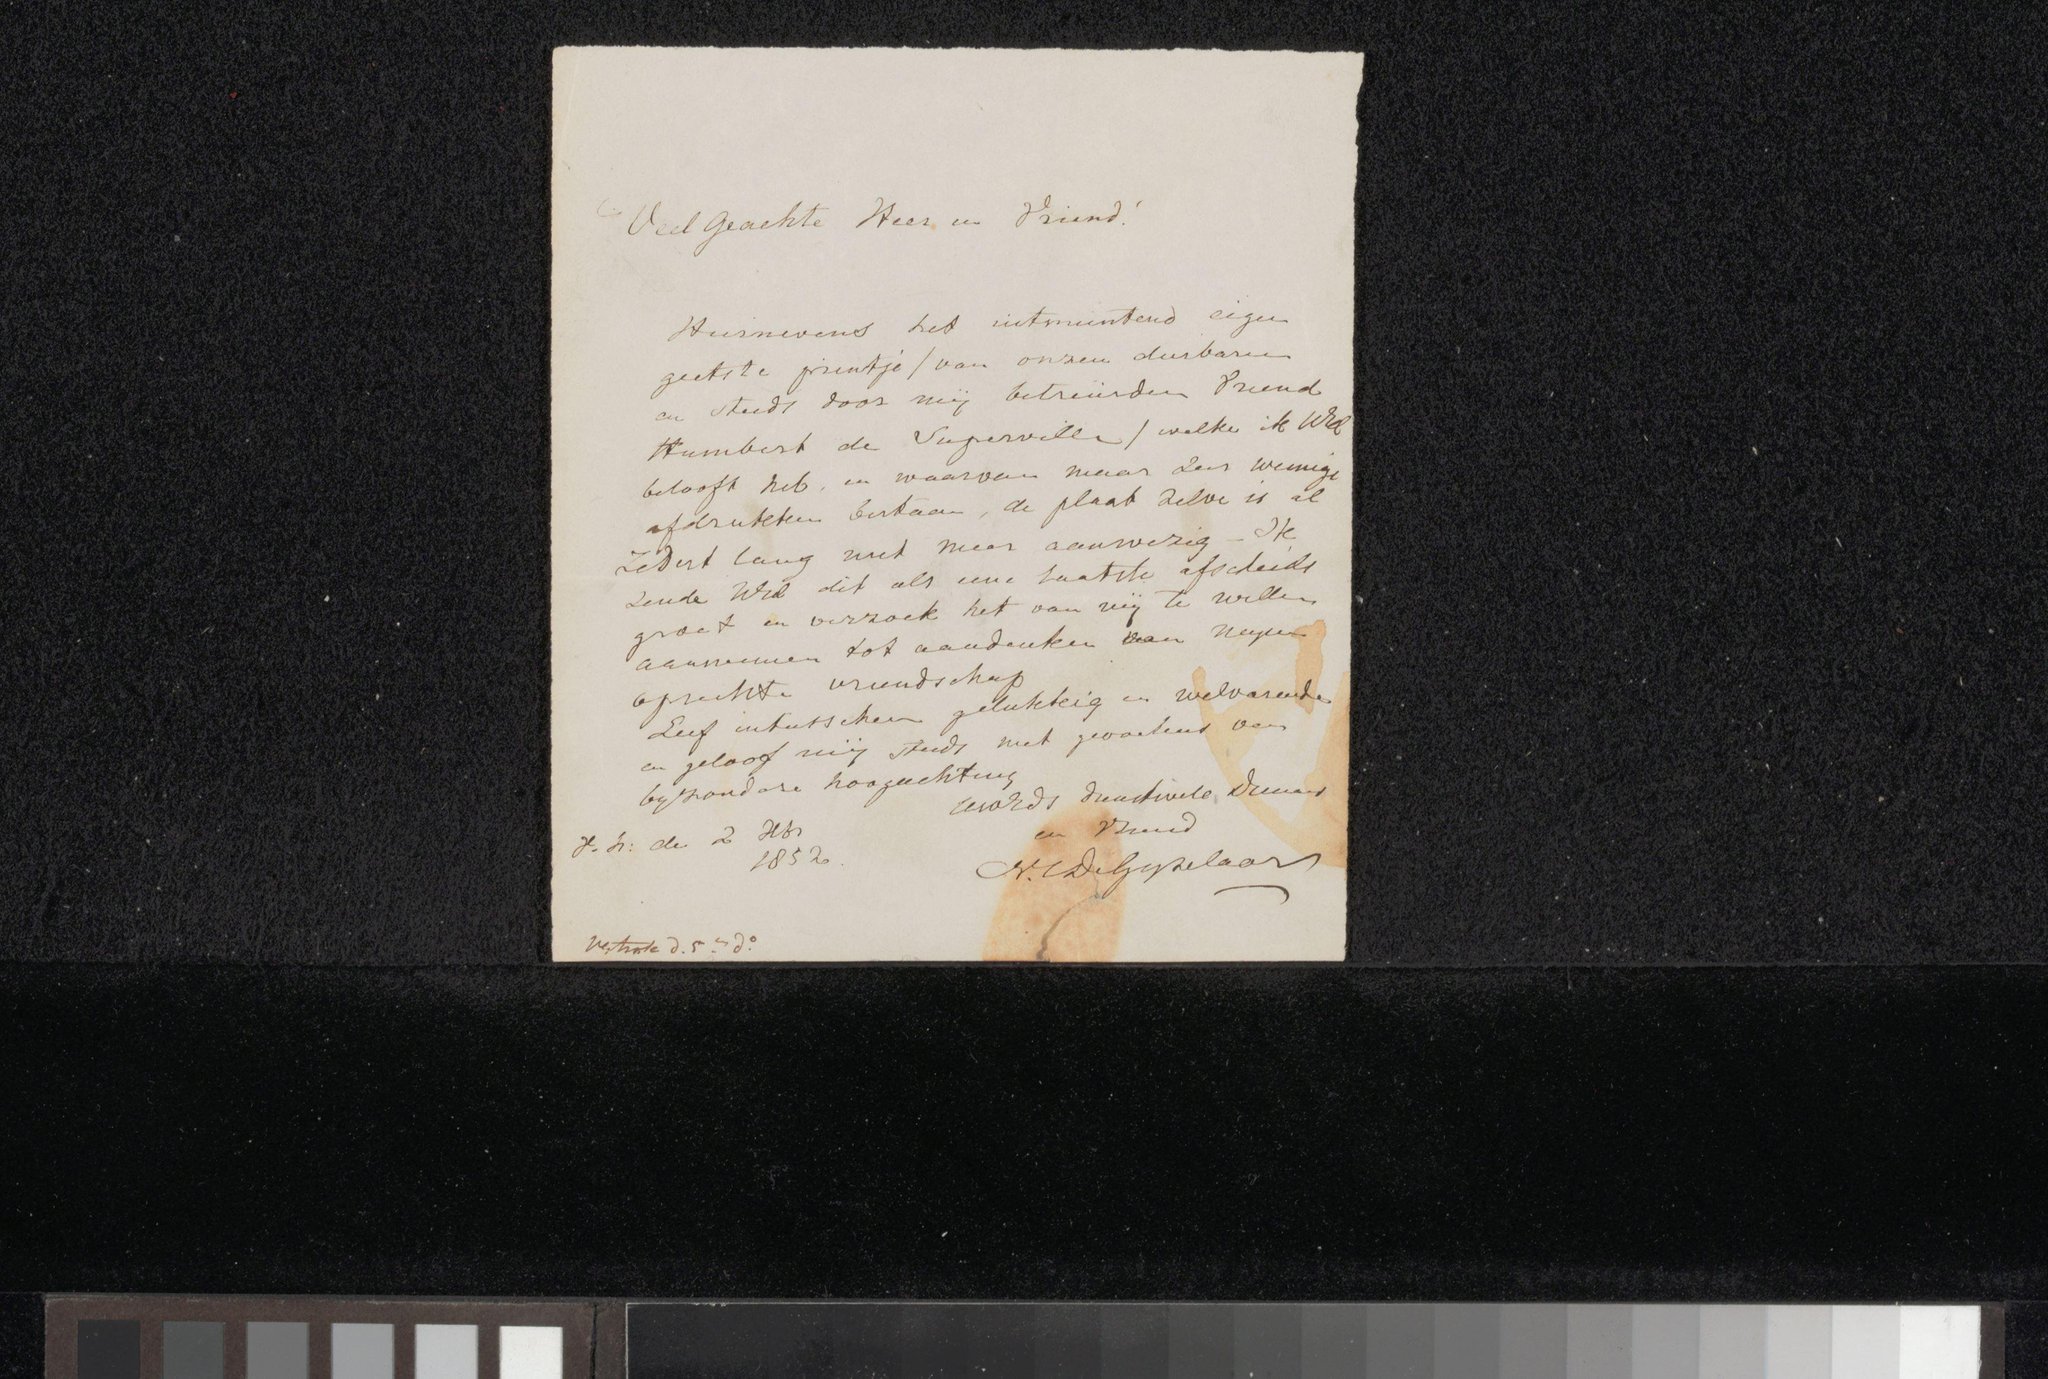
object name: letter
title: Brief aan anoniem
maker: nicolaas cornelis de gijselaar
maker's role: print maker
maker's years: 1792-1873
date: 1856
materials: ink, paper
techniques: pen, writing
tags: leiden, painter, david pièrre giottino humbert de superville, the graphic arts